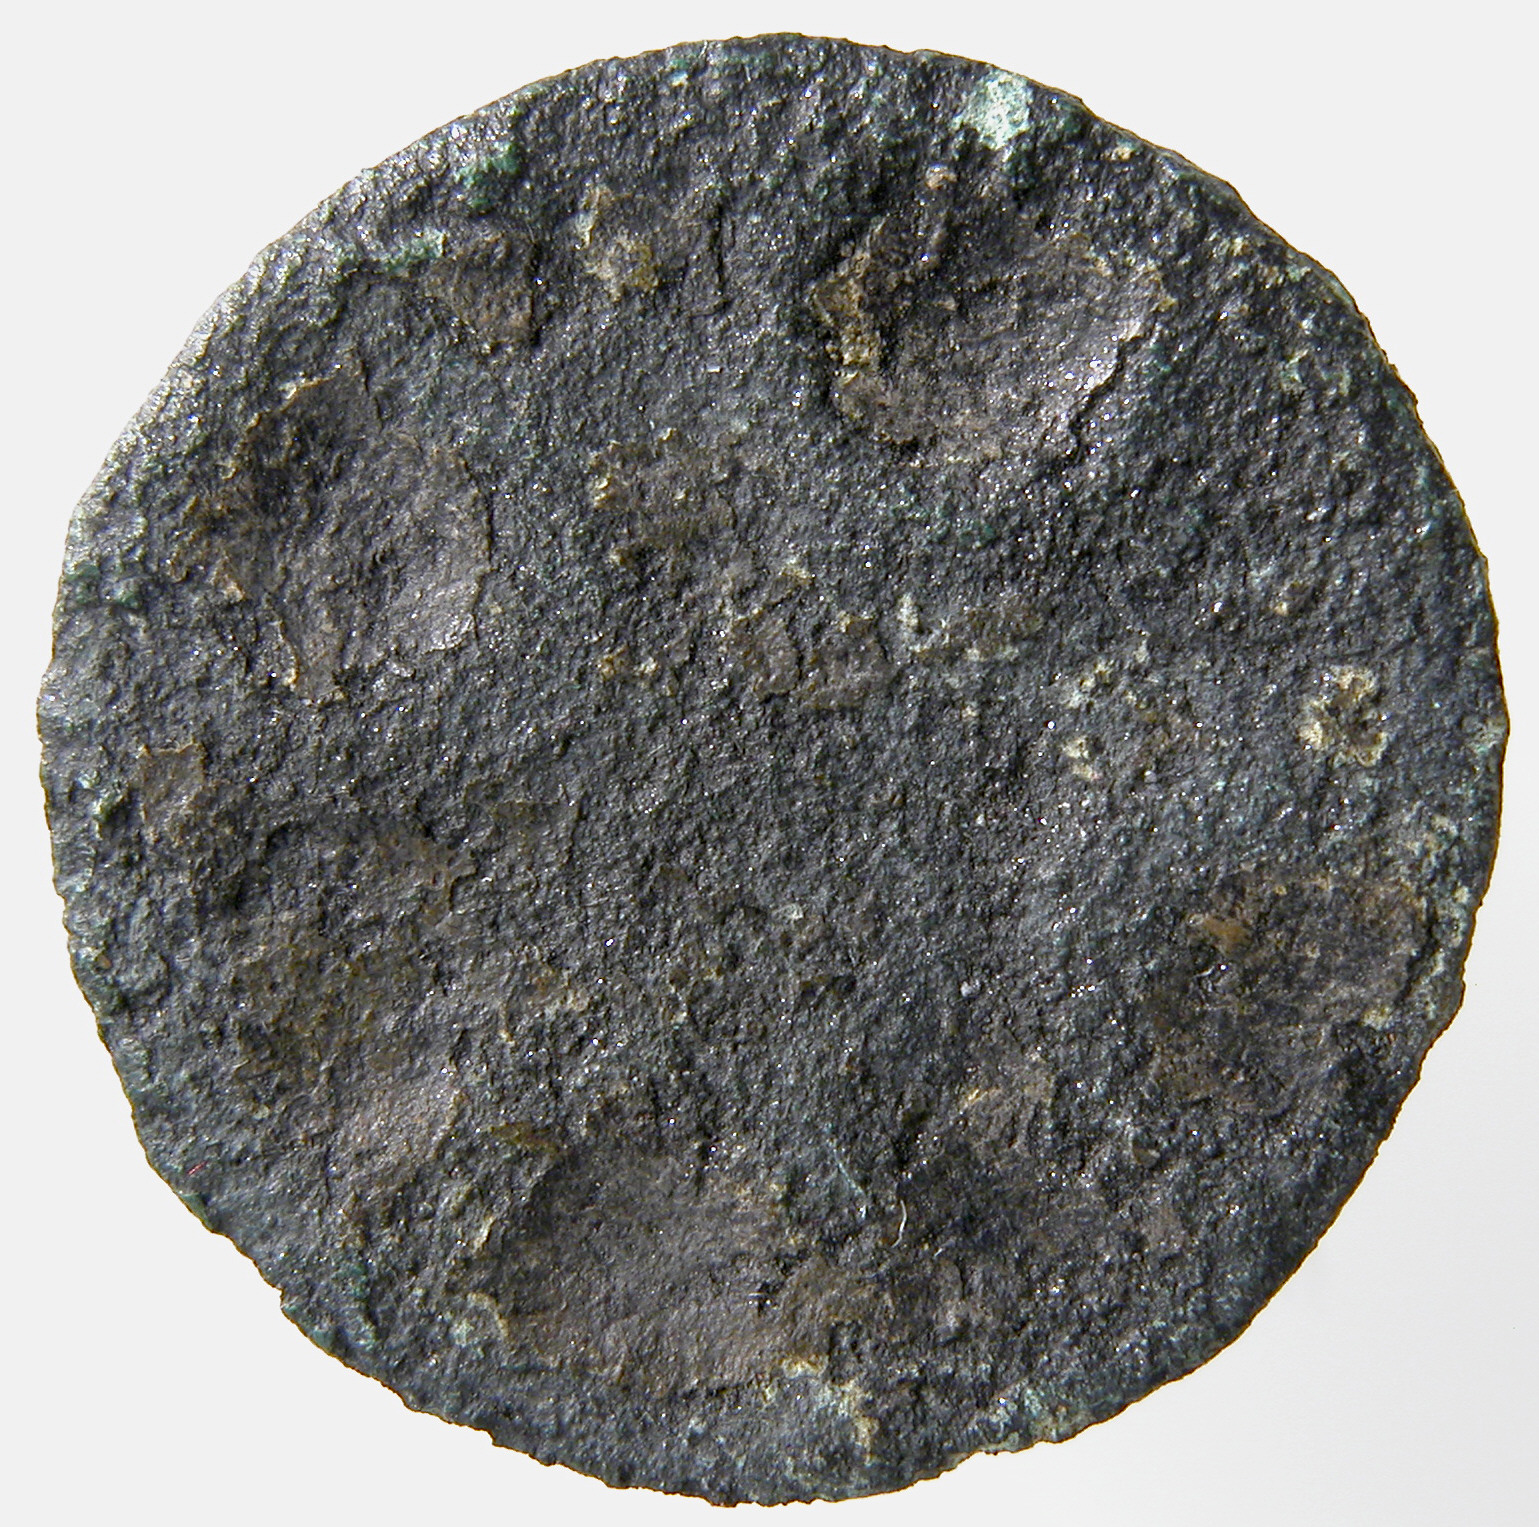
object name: brooch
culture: merovingian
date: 701-900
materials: copper alloy, enamel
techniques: enamel